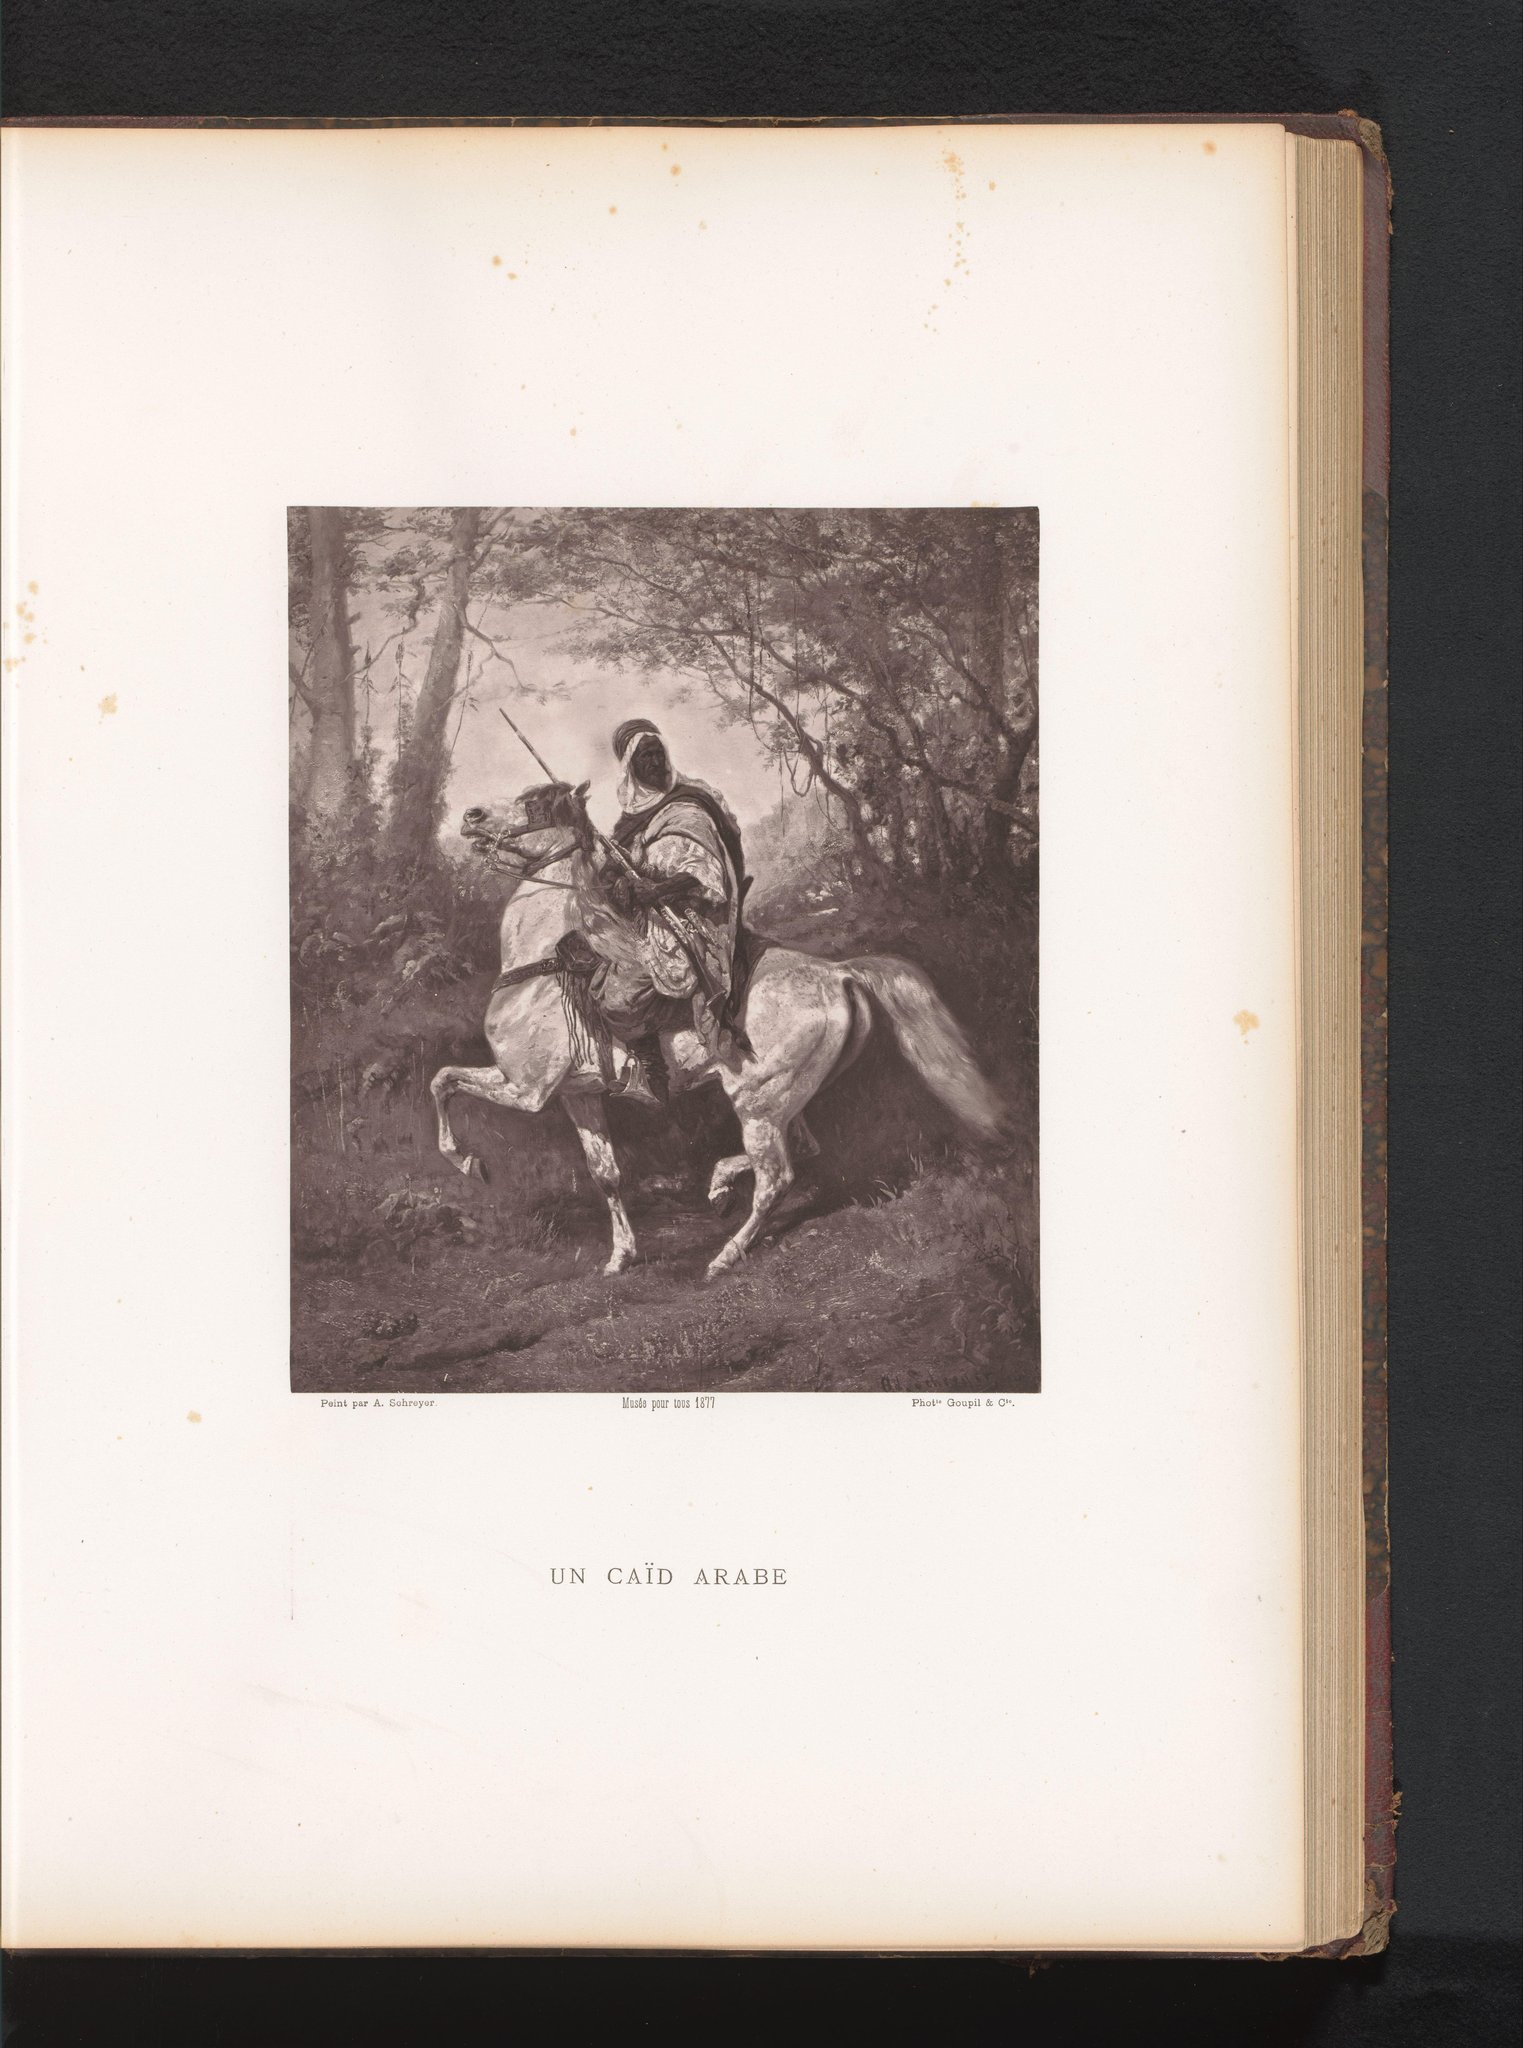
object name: page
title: Reproductie van een schilderij van een Arabische leider te paard door Christian Adolf Schreyer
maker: christian adolf schreyer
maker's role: painter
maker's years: 1828-1899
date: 1872-1879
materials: paper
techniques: woodburytype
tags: riding a horse, ass, or mule; rider, horseman, commander-in-chief, general, marshal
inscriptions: inscription: ‘Musée pour tous 1877’